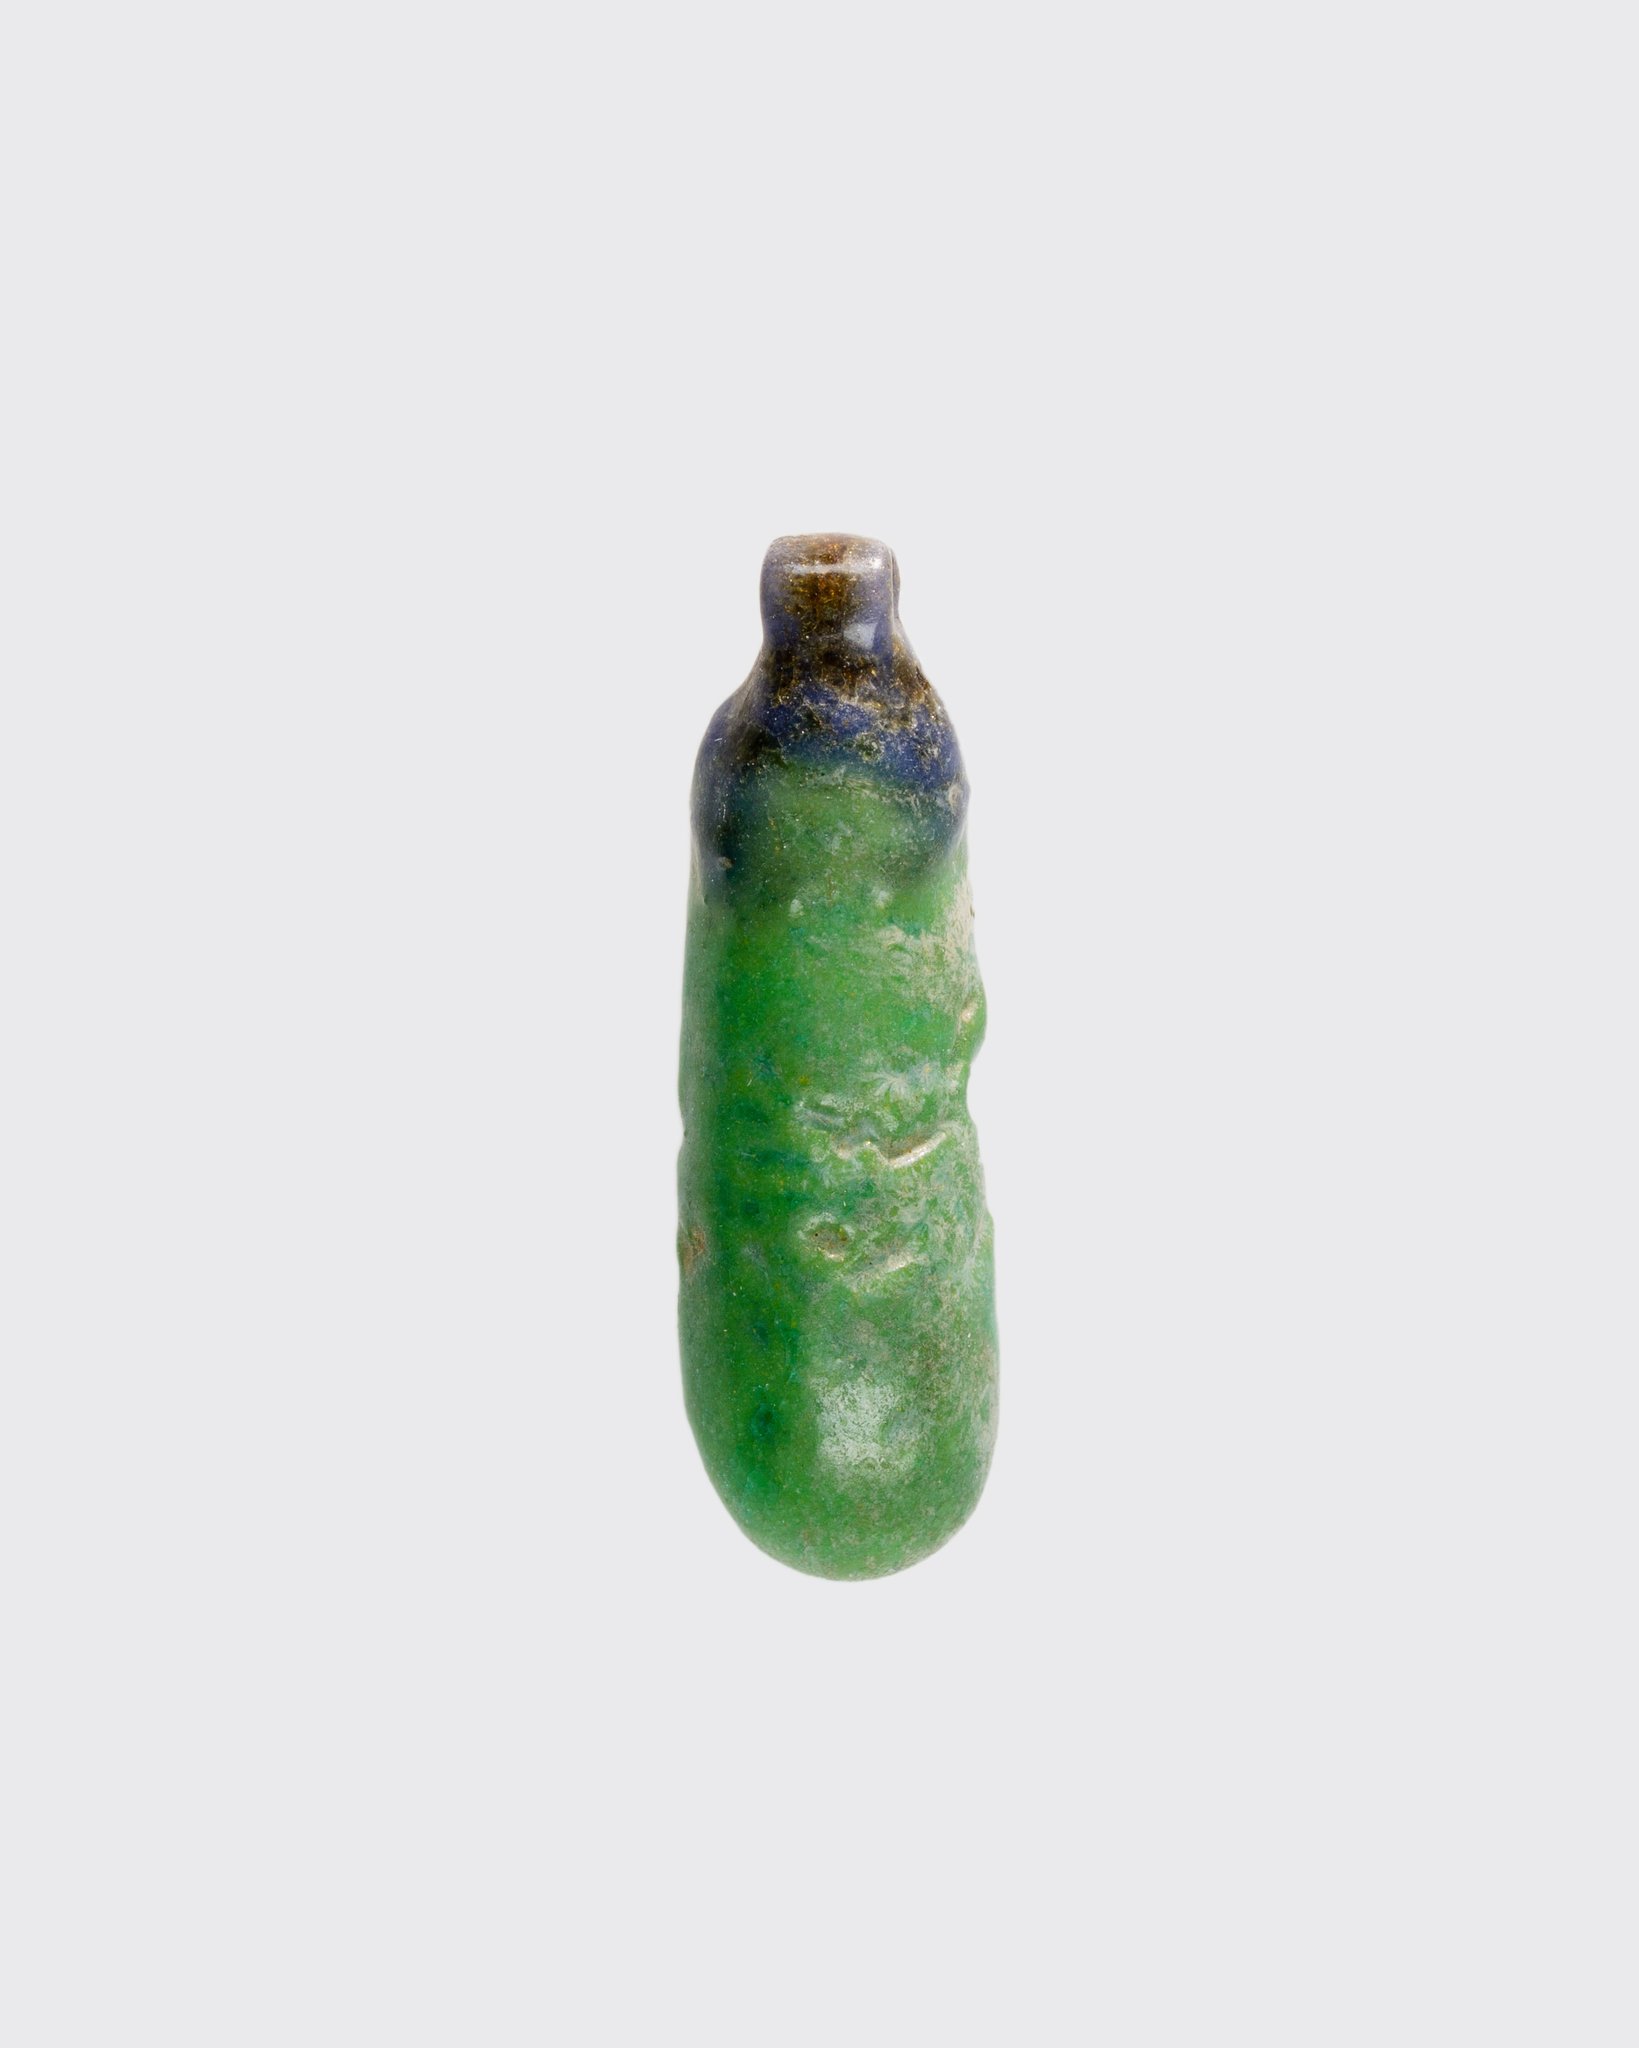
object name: pendant, date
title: Date Pendant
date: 1390-1352 BCE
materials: faience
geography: egypt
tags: fruit